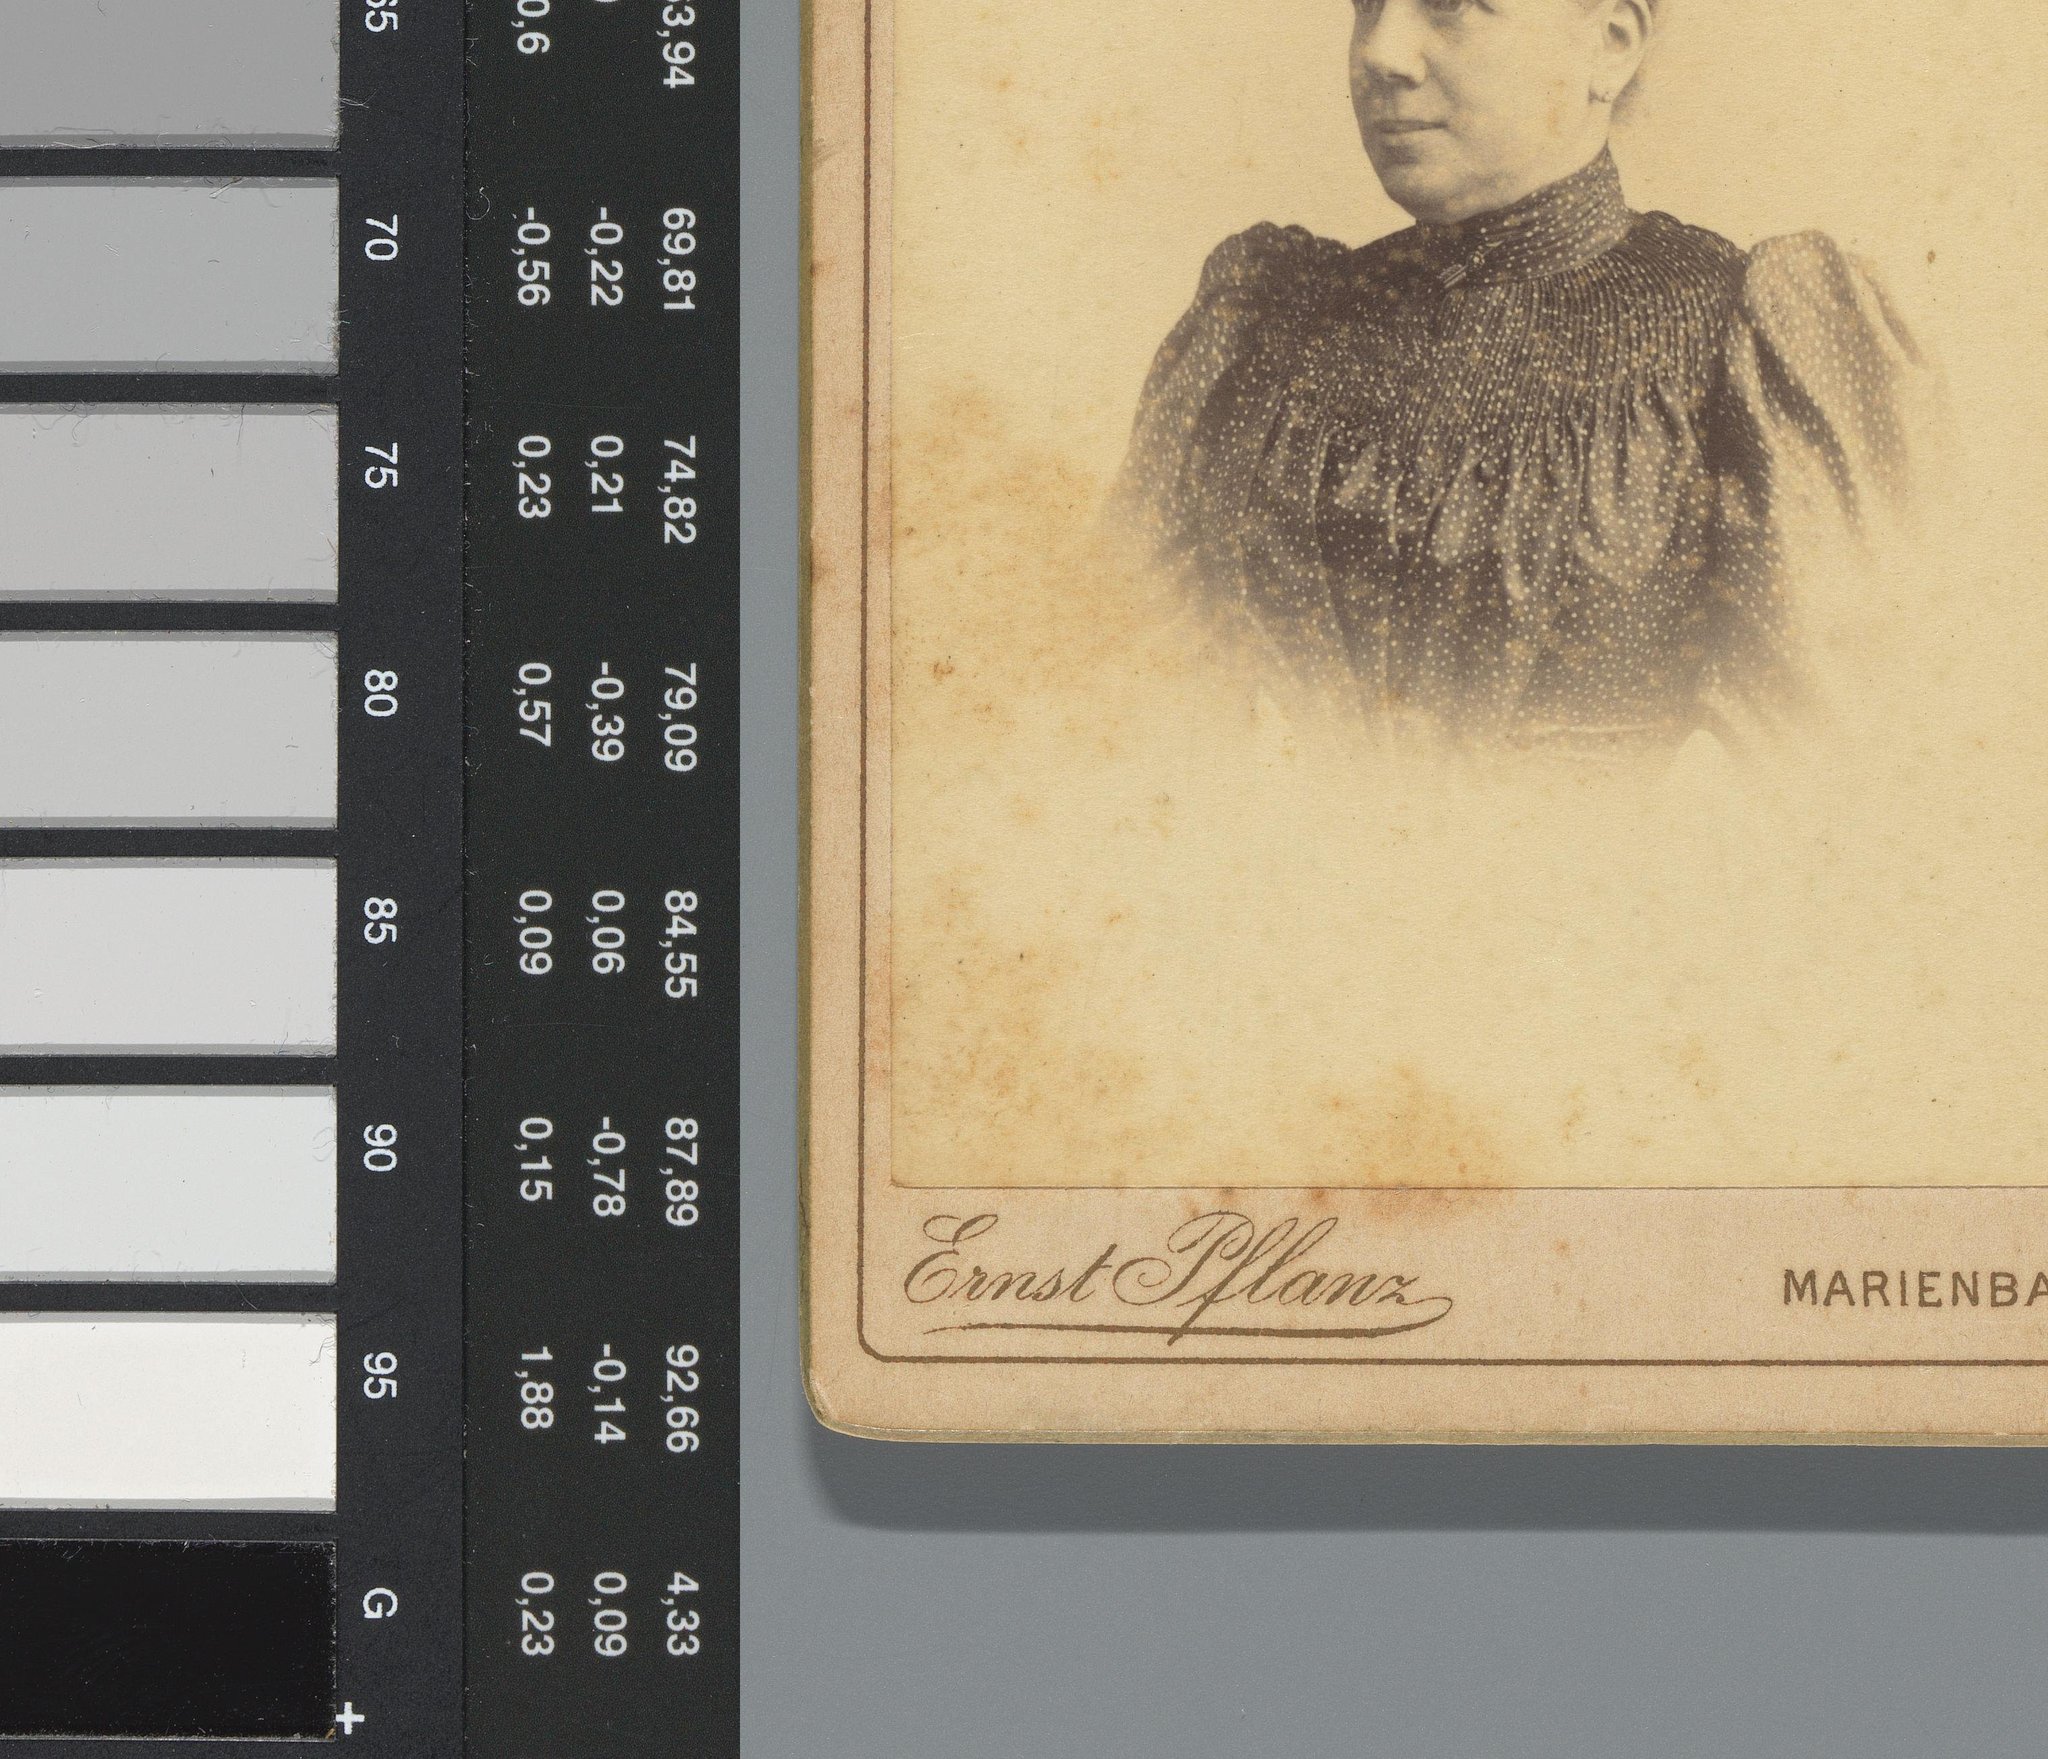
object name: carte de visite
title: Portret van Carolina Frederika Holle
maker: ernst pflanz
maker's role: painter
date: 1865-1885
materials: cardboard, photographic support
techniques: albumen print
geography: marienbad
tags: carolina frederika van den berg-holle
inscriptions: name: ‘CF. van den Berg- / Holle’, name: ‘Ernst Pflanz MARIENBAD’, name: ‘VIRIBUS UNITIS / ERNST PFLANZ MALER / & PHOTOGRAPH / MARIENBAD / WALDQUELL ALLEE / VILLA PFLANZ’